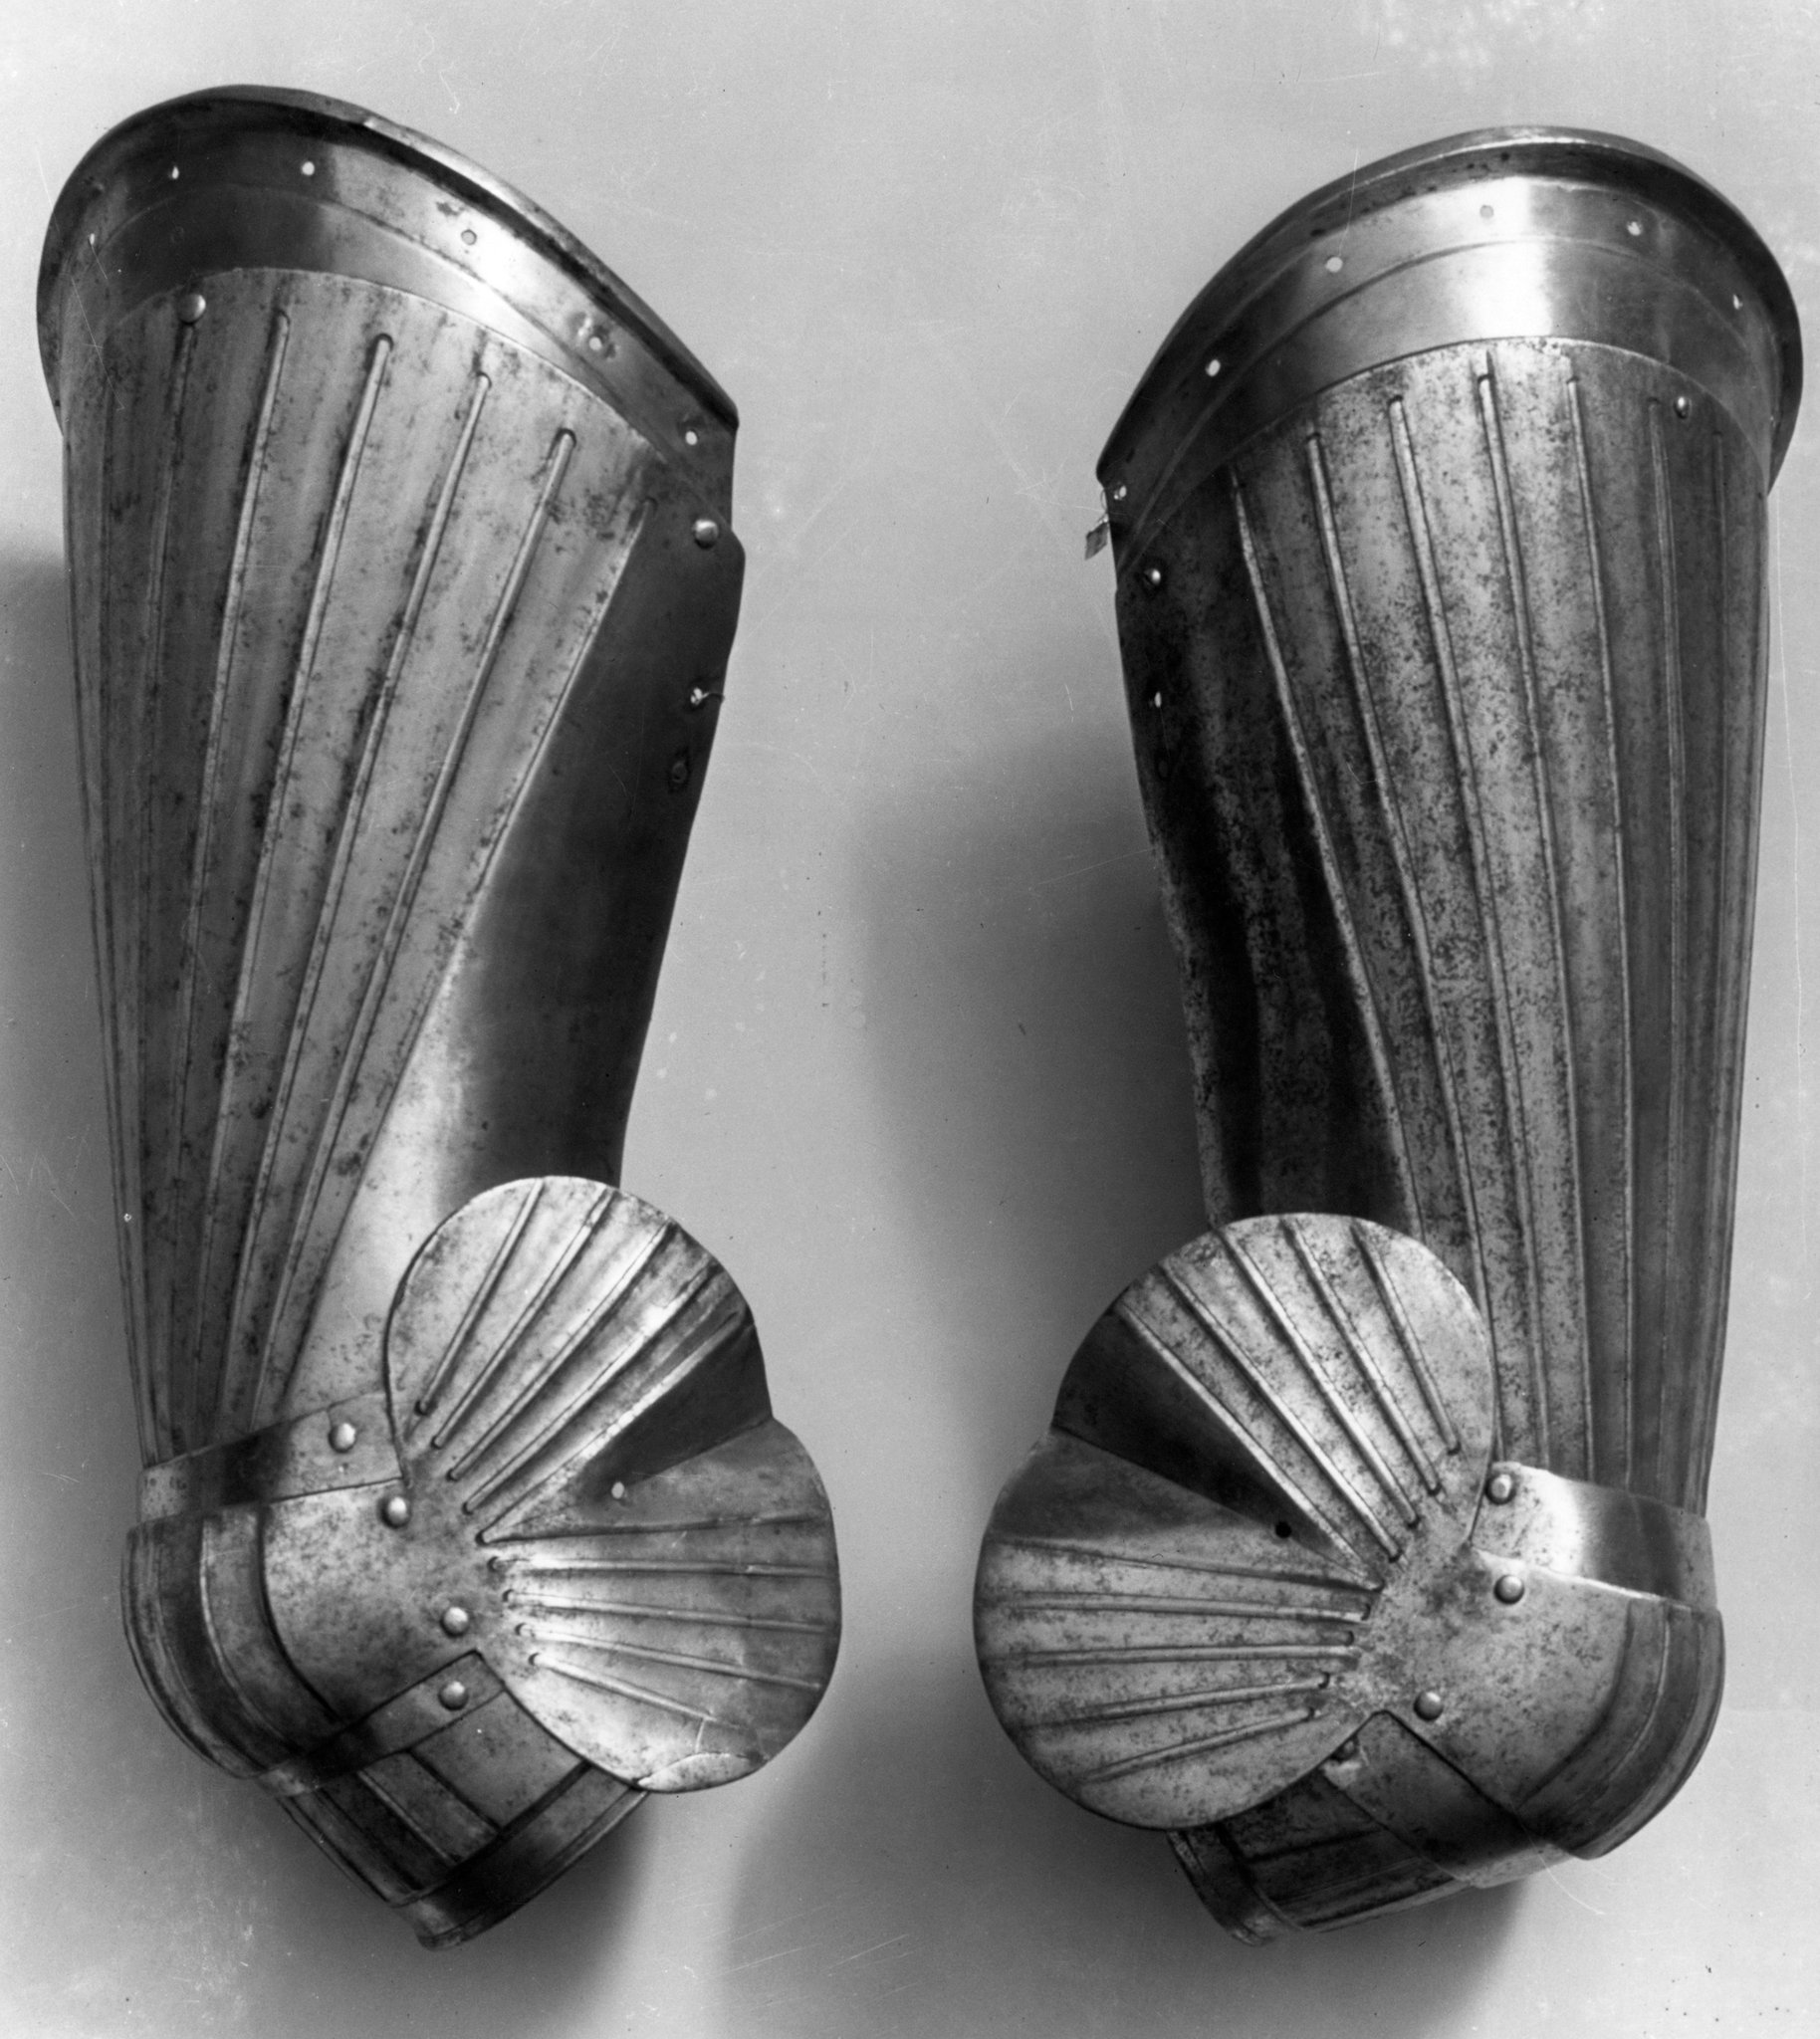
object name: pair of thigh defense cuisse with knee defense poleyns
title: Pair of Thigh Defenses (Cuisses) with Knee Defenses (Poleyns)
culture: german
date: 1501-1600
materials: steel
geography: germany